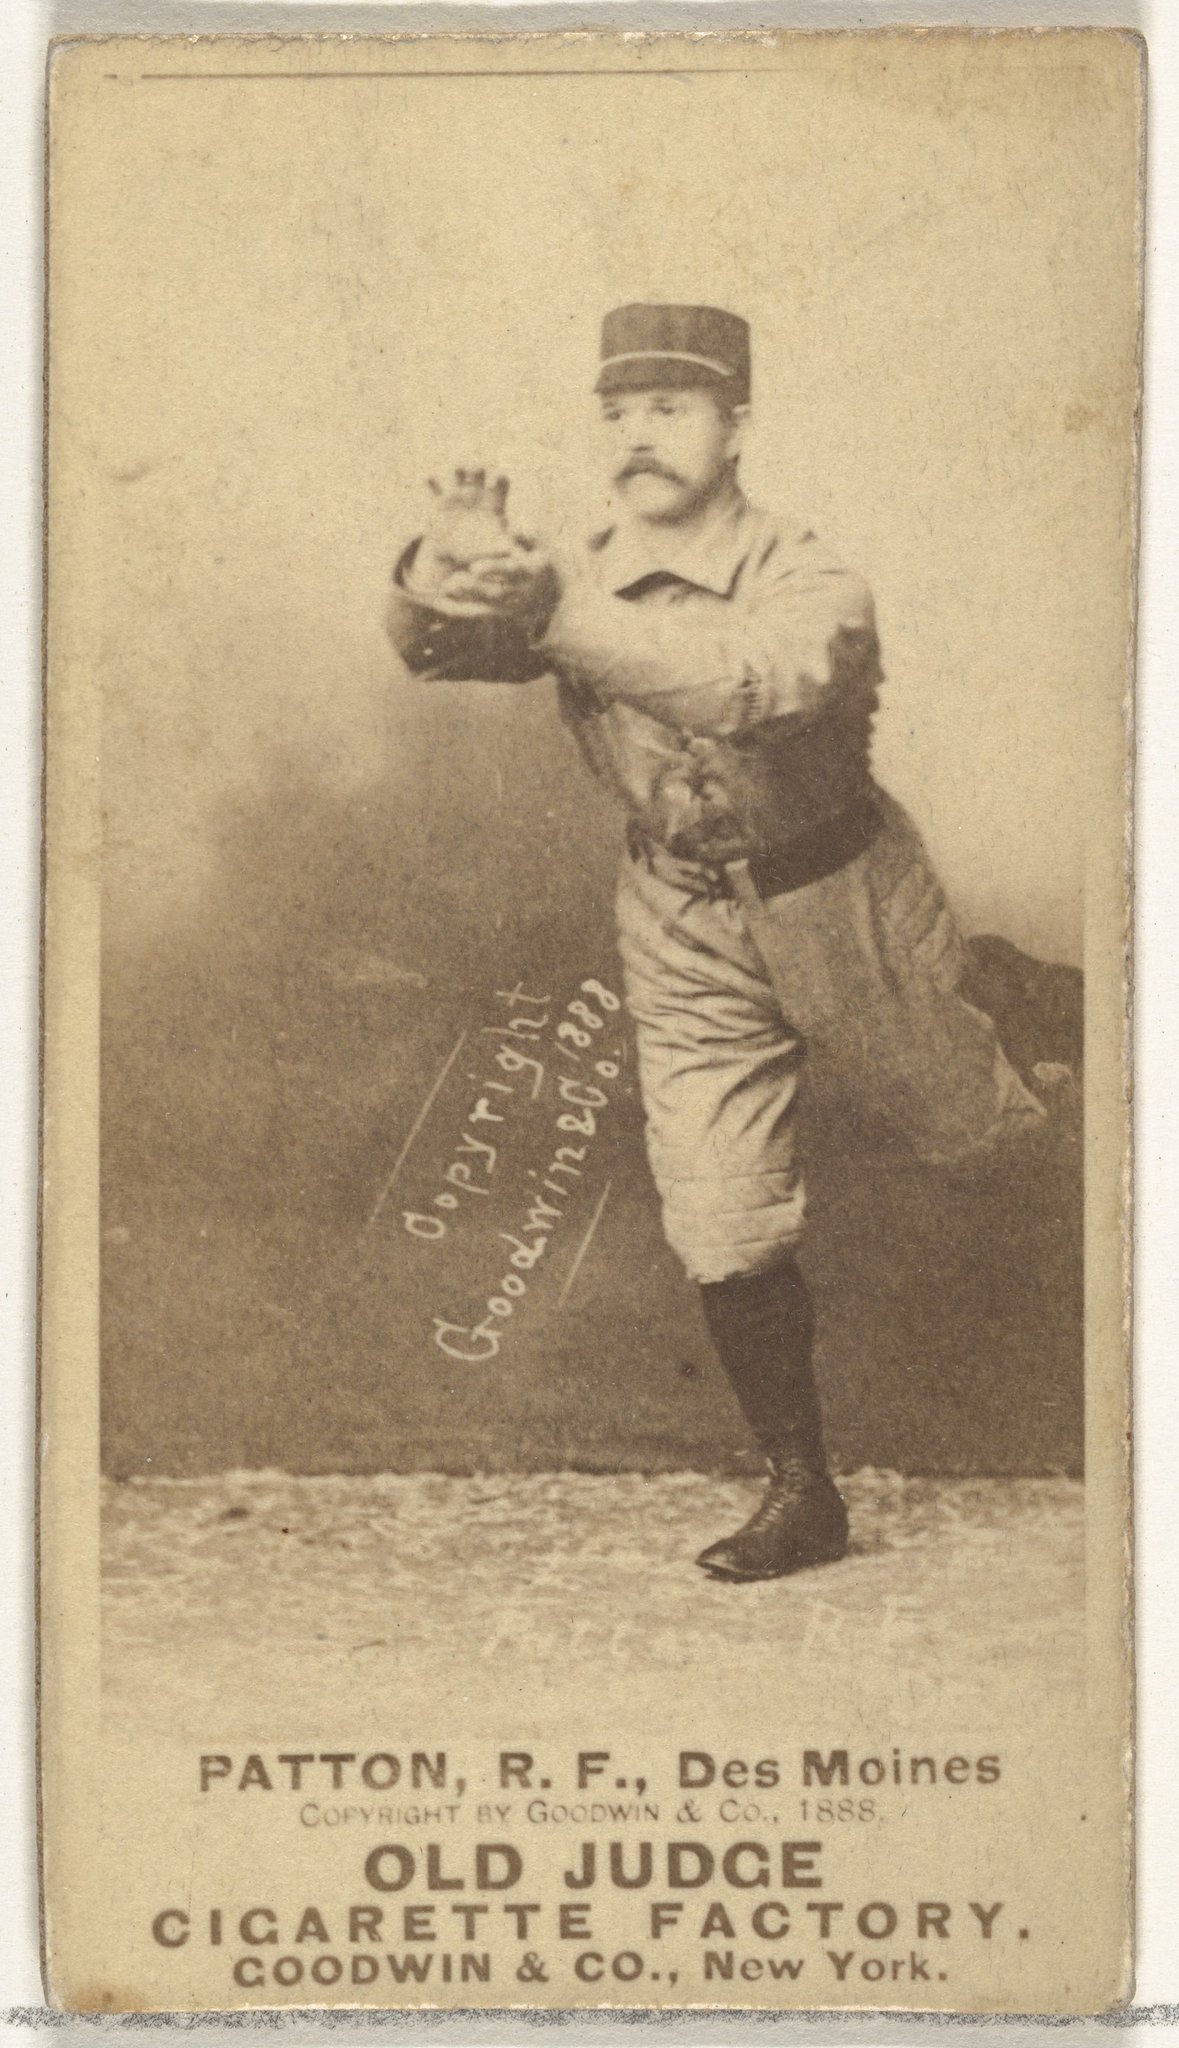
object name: baseball card, photograph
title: Patton, Right Field, Des Moines Prohibitionists, from the Old Judge series (N172) for Old Judge Cigarettes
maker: goodwin & company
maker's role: publisher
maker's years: 1850-1950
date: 1888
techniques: albumen silver print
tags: men,portraits,baseball,athletes